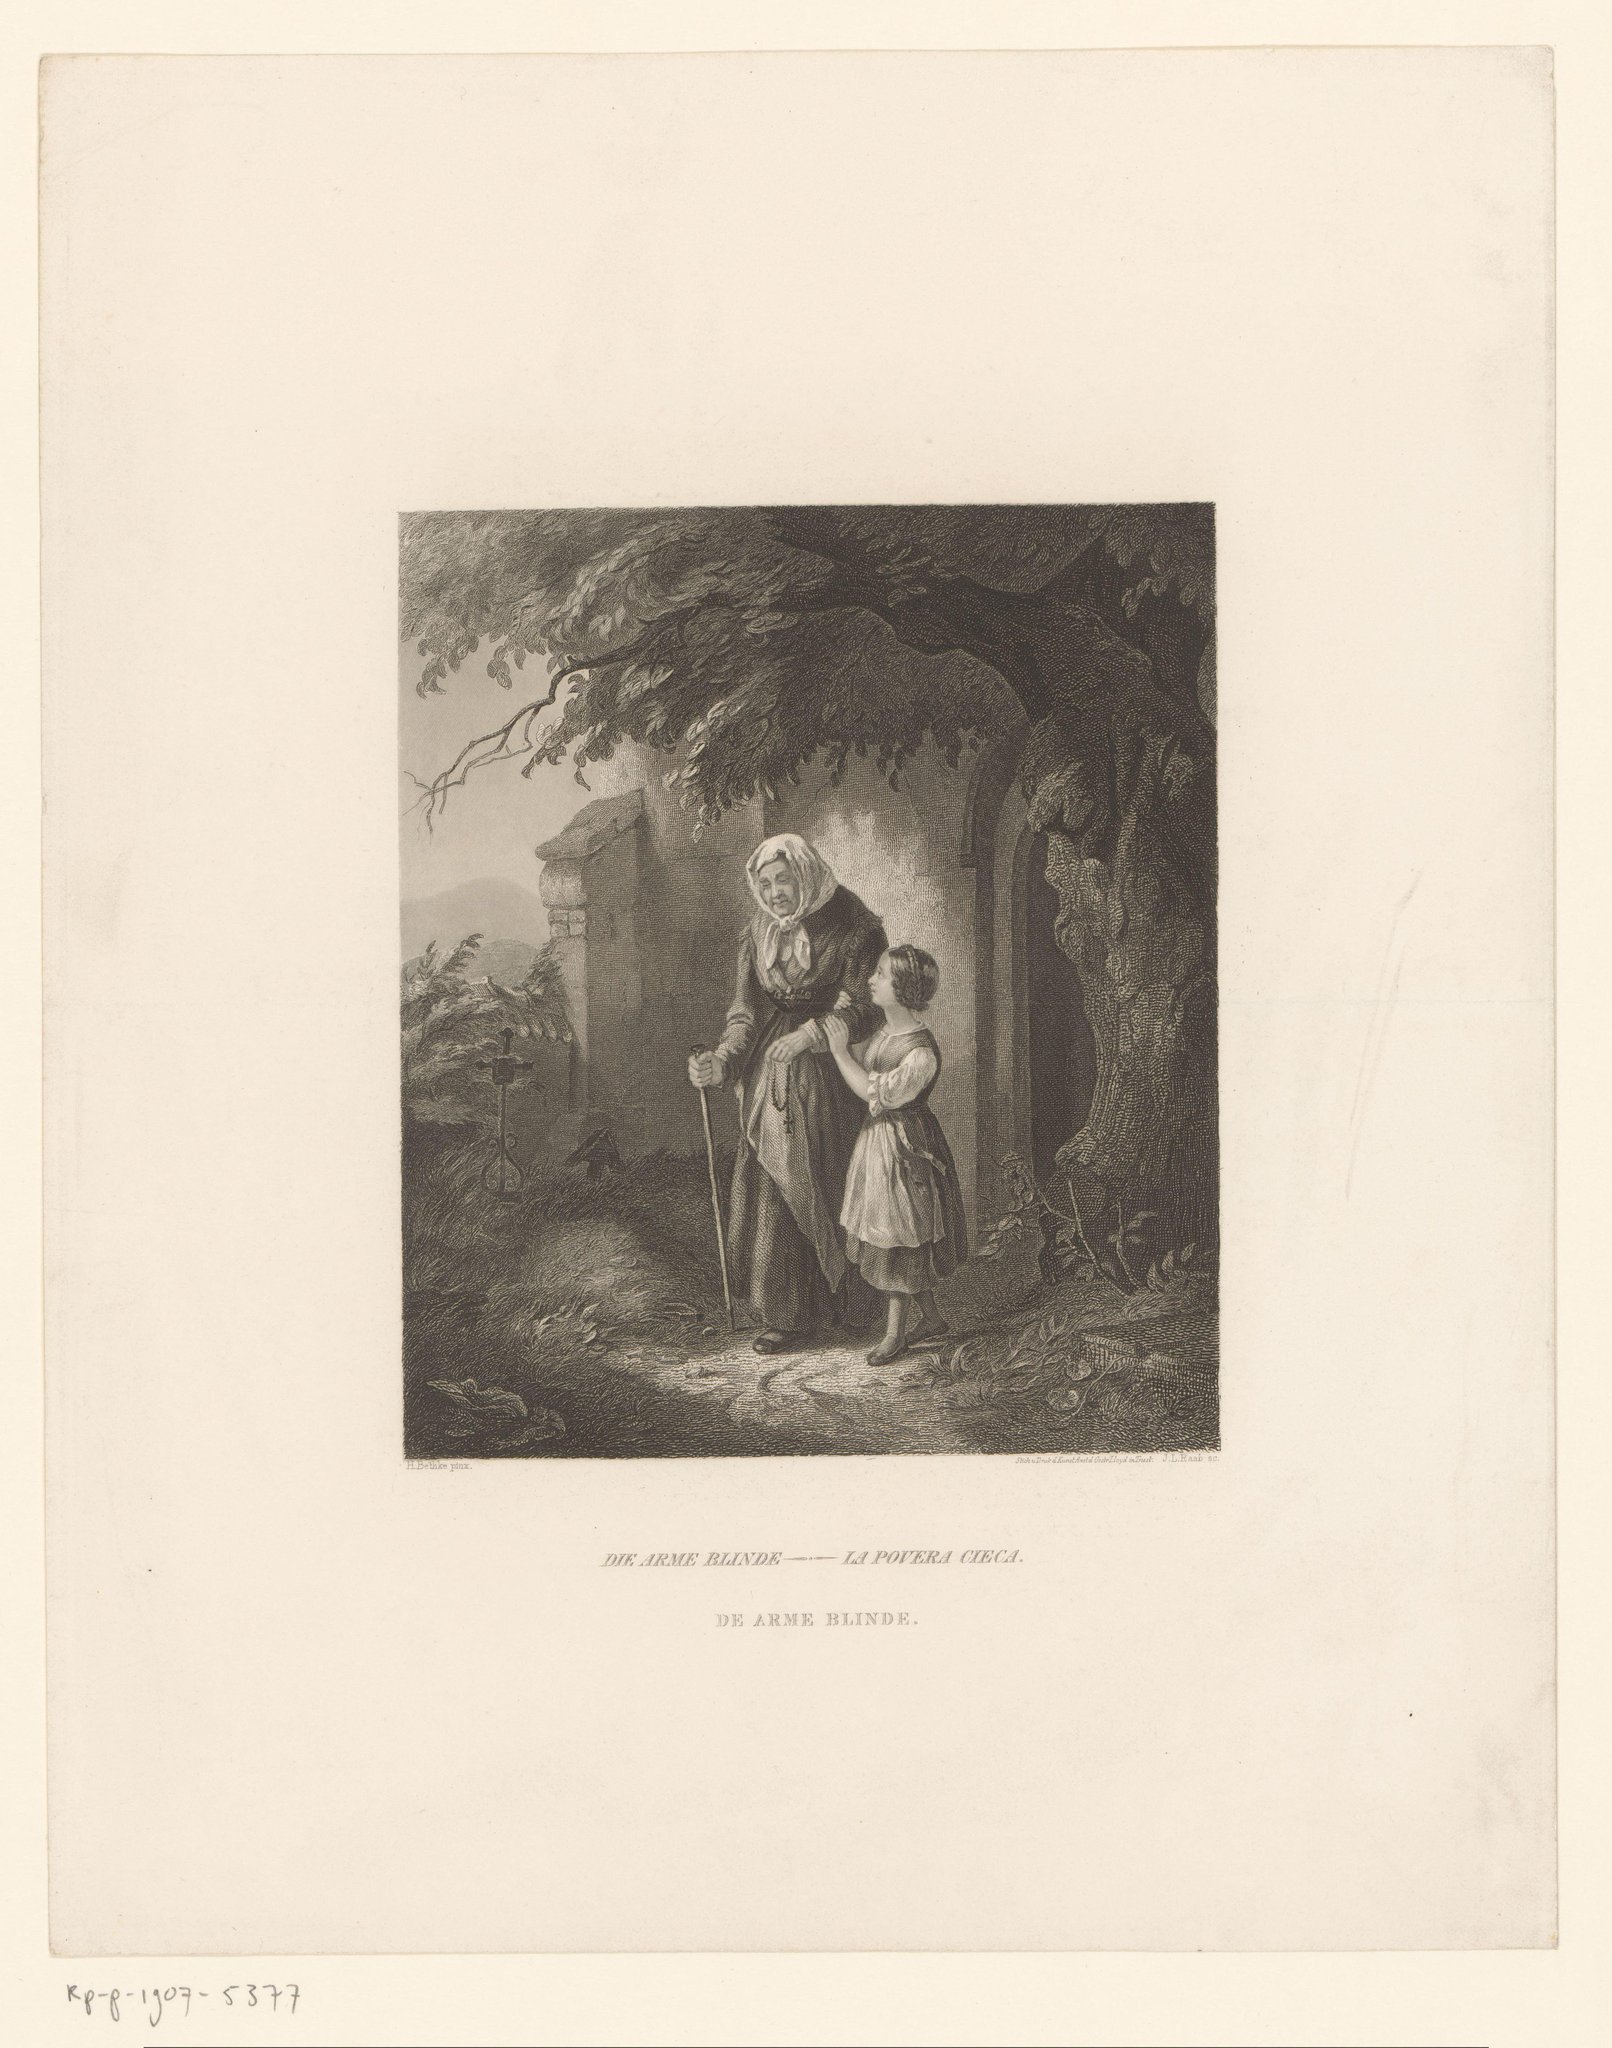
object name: print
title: Blinde vrouw en een meisje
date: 1840-1899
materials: paper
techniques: engraving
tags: blind, blindness, child (at home) - aa - girl, the poor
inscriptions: collector's mark: Lugt 2228